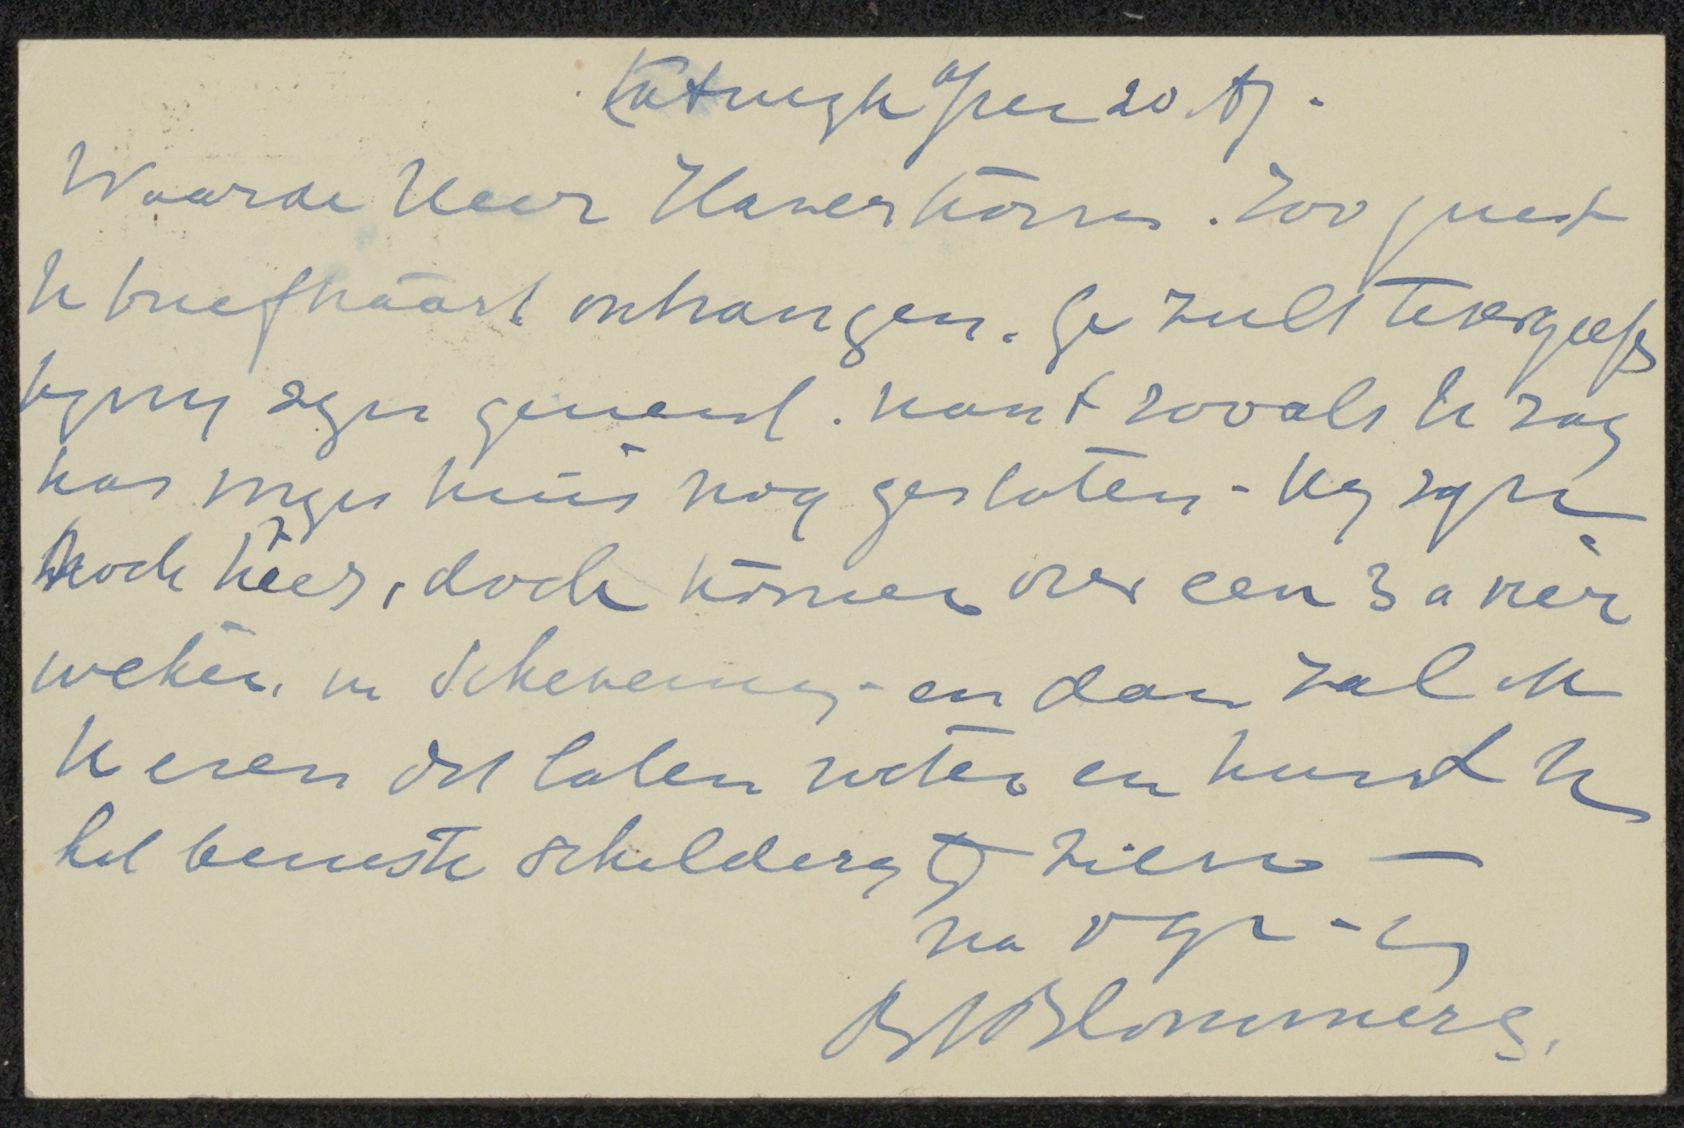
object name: postcard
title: Briefkaart aan Pieter Haverkorn van Rijsewijk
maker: bernardus johannes blommers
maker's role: draughtsman, print maker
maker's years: 1845-1914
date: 1910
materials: cardboard, ink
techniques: pen, writing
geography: katwijk aan zee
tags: pieter haverkorn van rijsewijk, painting (including book-illumination, miniature-painting)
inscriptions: collector's mark: ‘RPK’